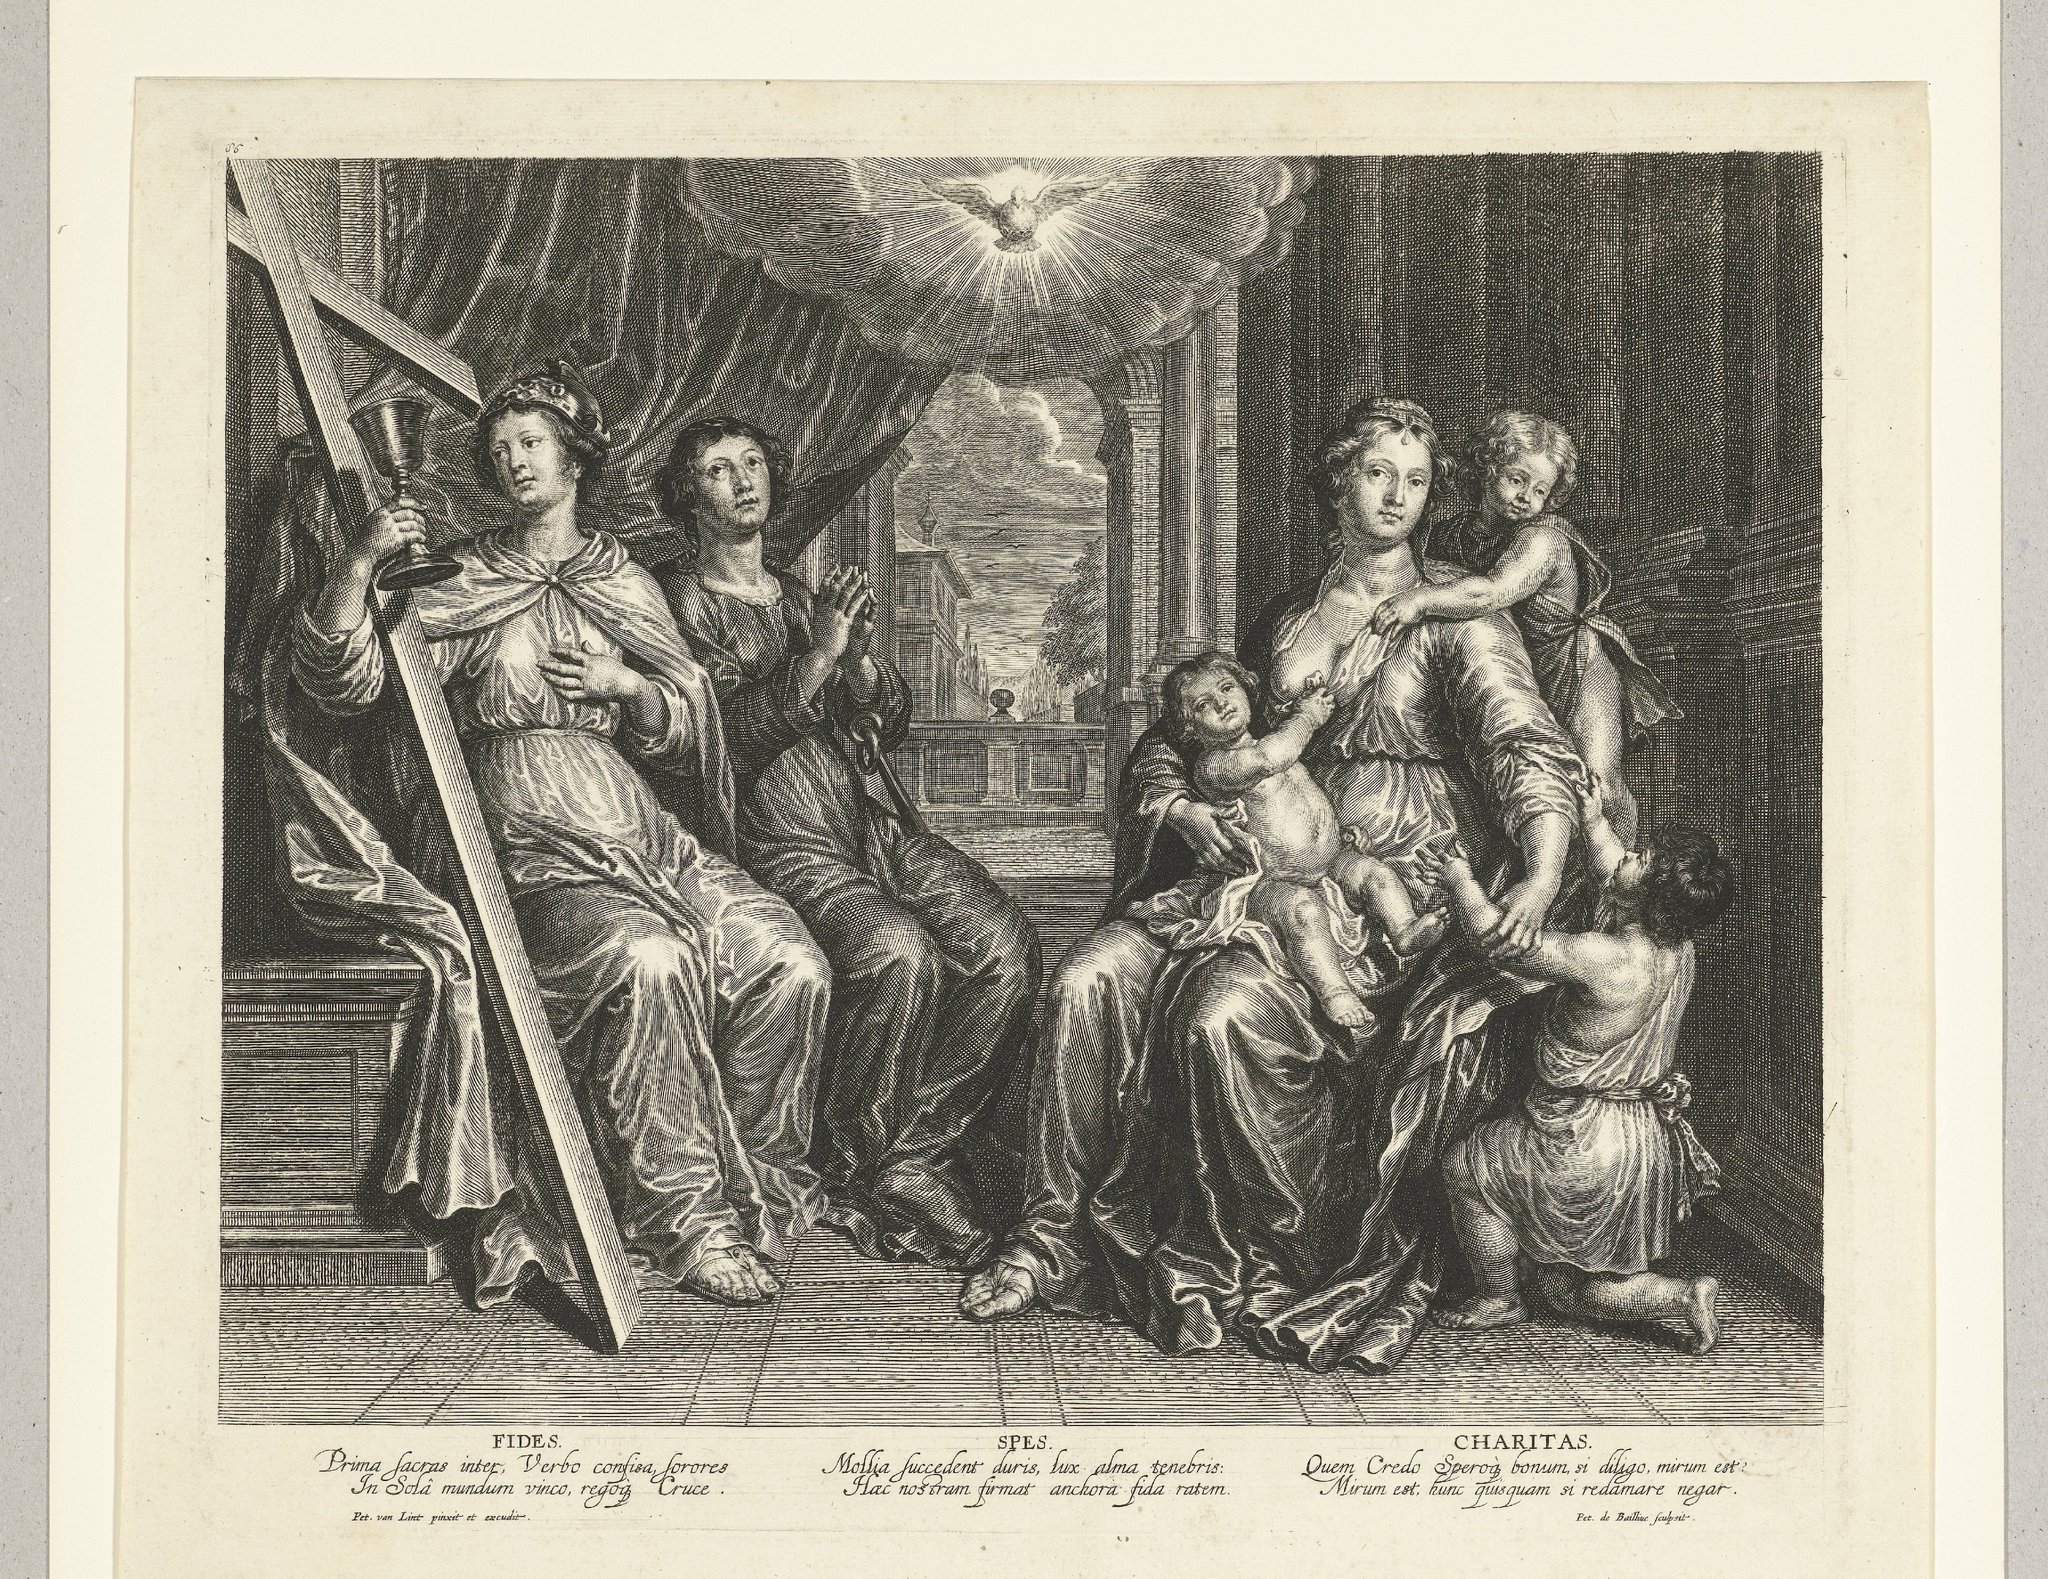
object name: print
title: Allegorie met drie goddelijke deugden Geloof (Fides) en Hoop (Spes) en Liefde (Caritas)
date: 1623-1660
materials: paper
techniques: engraving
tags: charity, 'caritas'; 'carità' (ripa) ~ one of the three theological virtues, faith, 'fides'; 'fede', 'fede catholica', 'fede christiana', 'fede christiana catholica' (ripa) ~ one of the three theological virtues, hope, 'spes'; 'speranza divina e certa' (ripa) ~ one of the three theological virtues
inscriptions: collector's mark: Lugt 240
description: Allegorie met drie vrouwelijke personificaties van goddelijke deugden Geloof (Fides) en Hoop (Spes) en Liefde (Caritas). Onder de voorstelling staan drie coupletten Latijnse tekst die verwijzen naar de deugden.